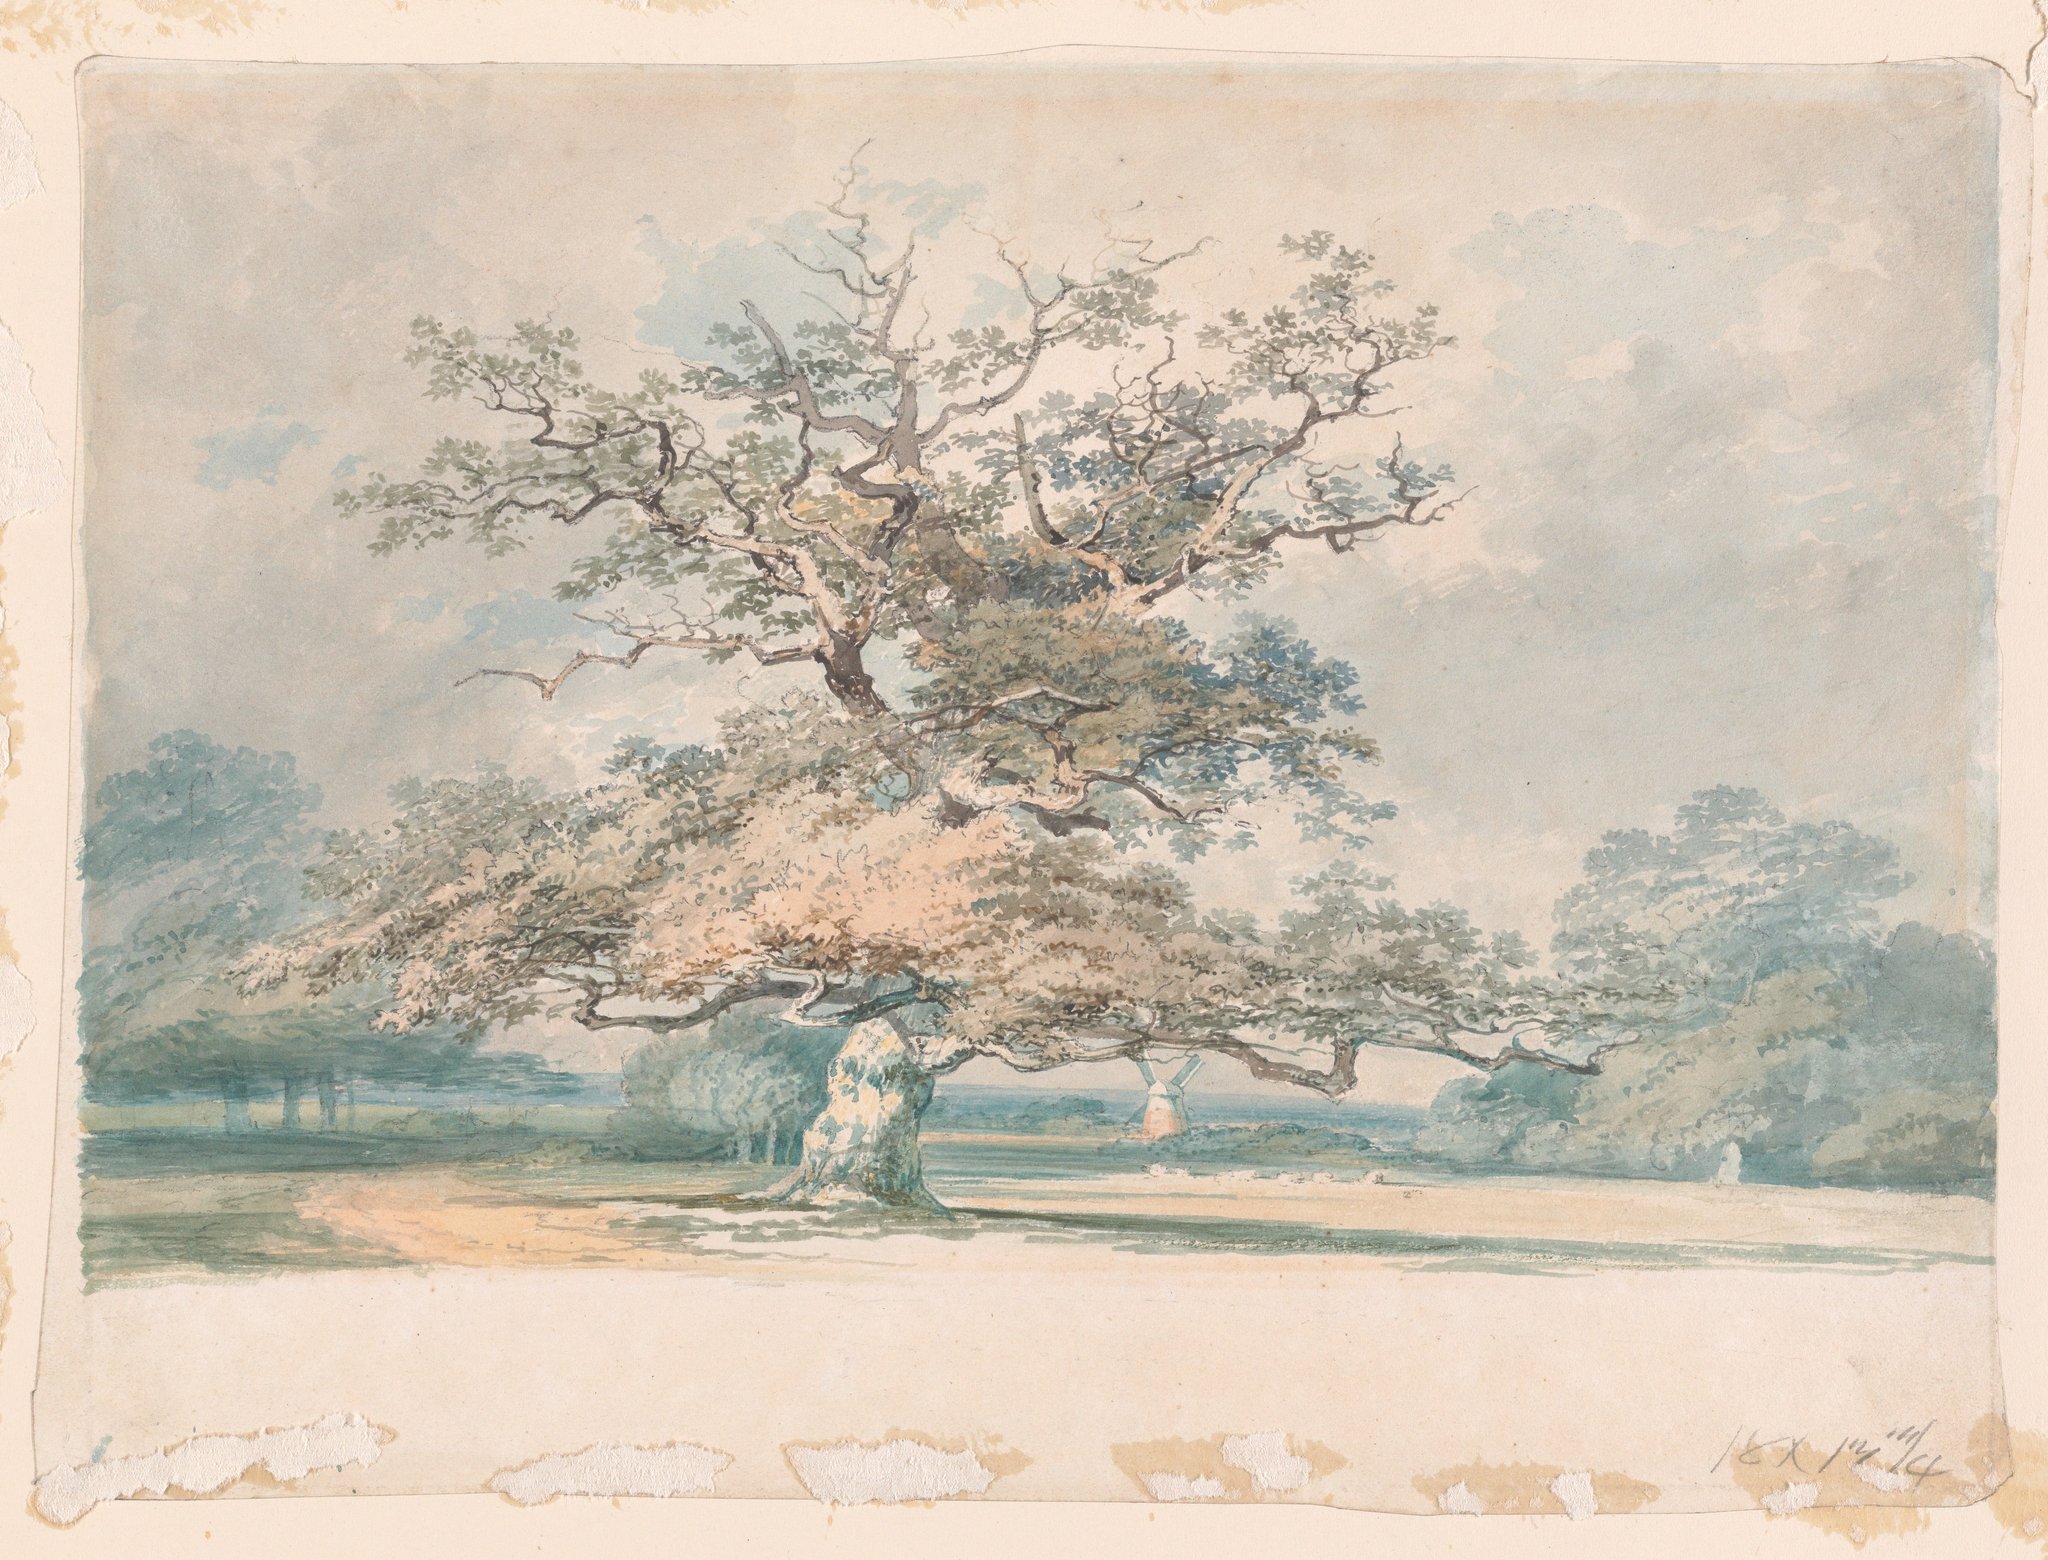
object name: drawing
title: A landscape with an old oak (or beech) tree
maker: joseph mallord william turner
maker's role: artist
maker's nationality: british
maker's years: 1775-1851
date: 1796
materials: graphite, watercolor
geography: great britain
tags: trees